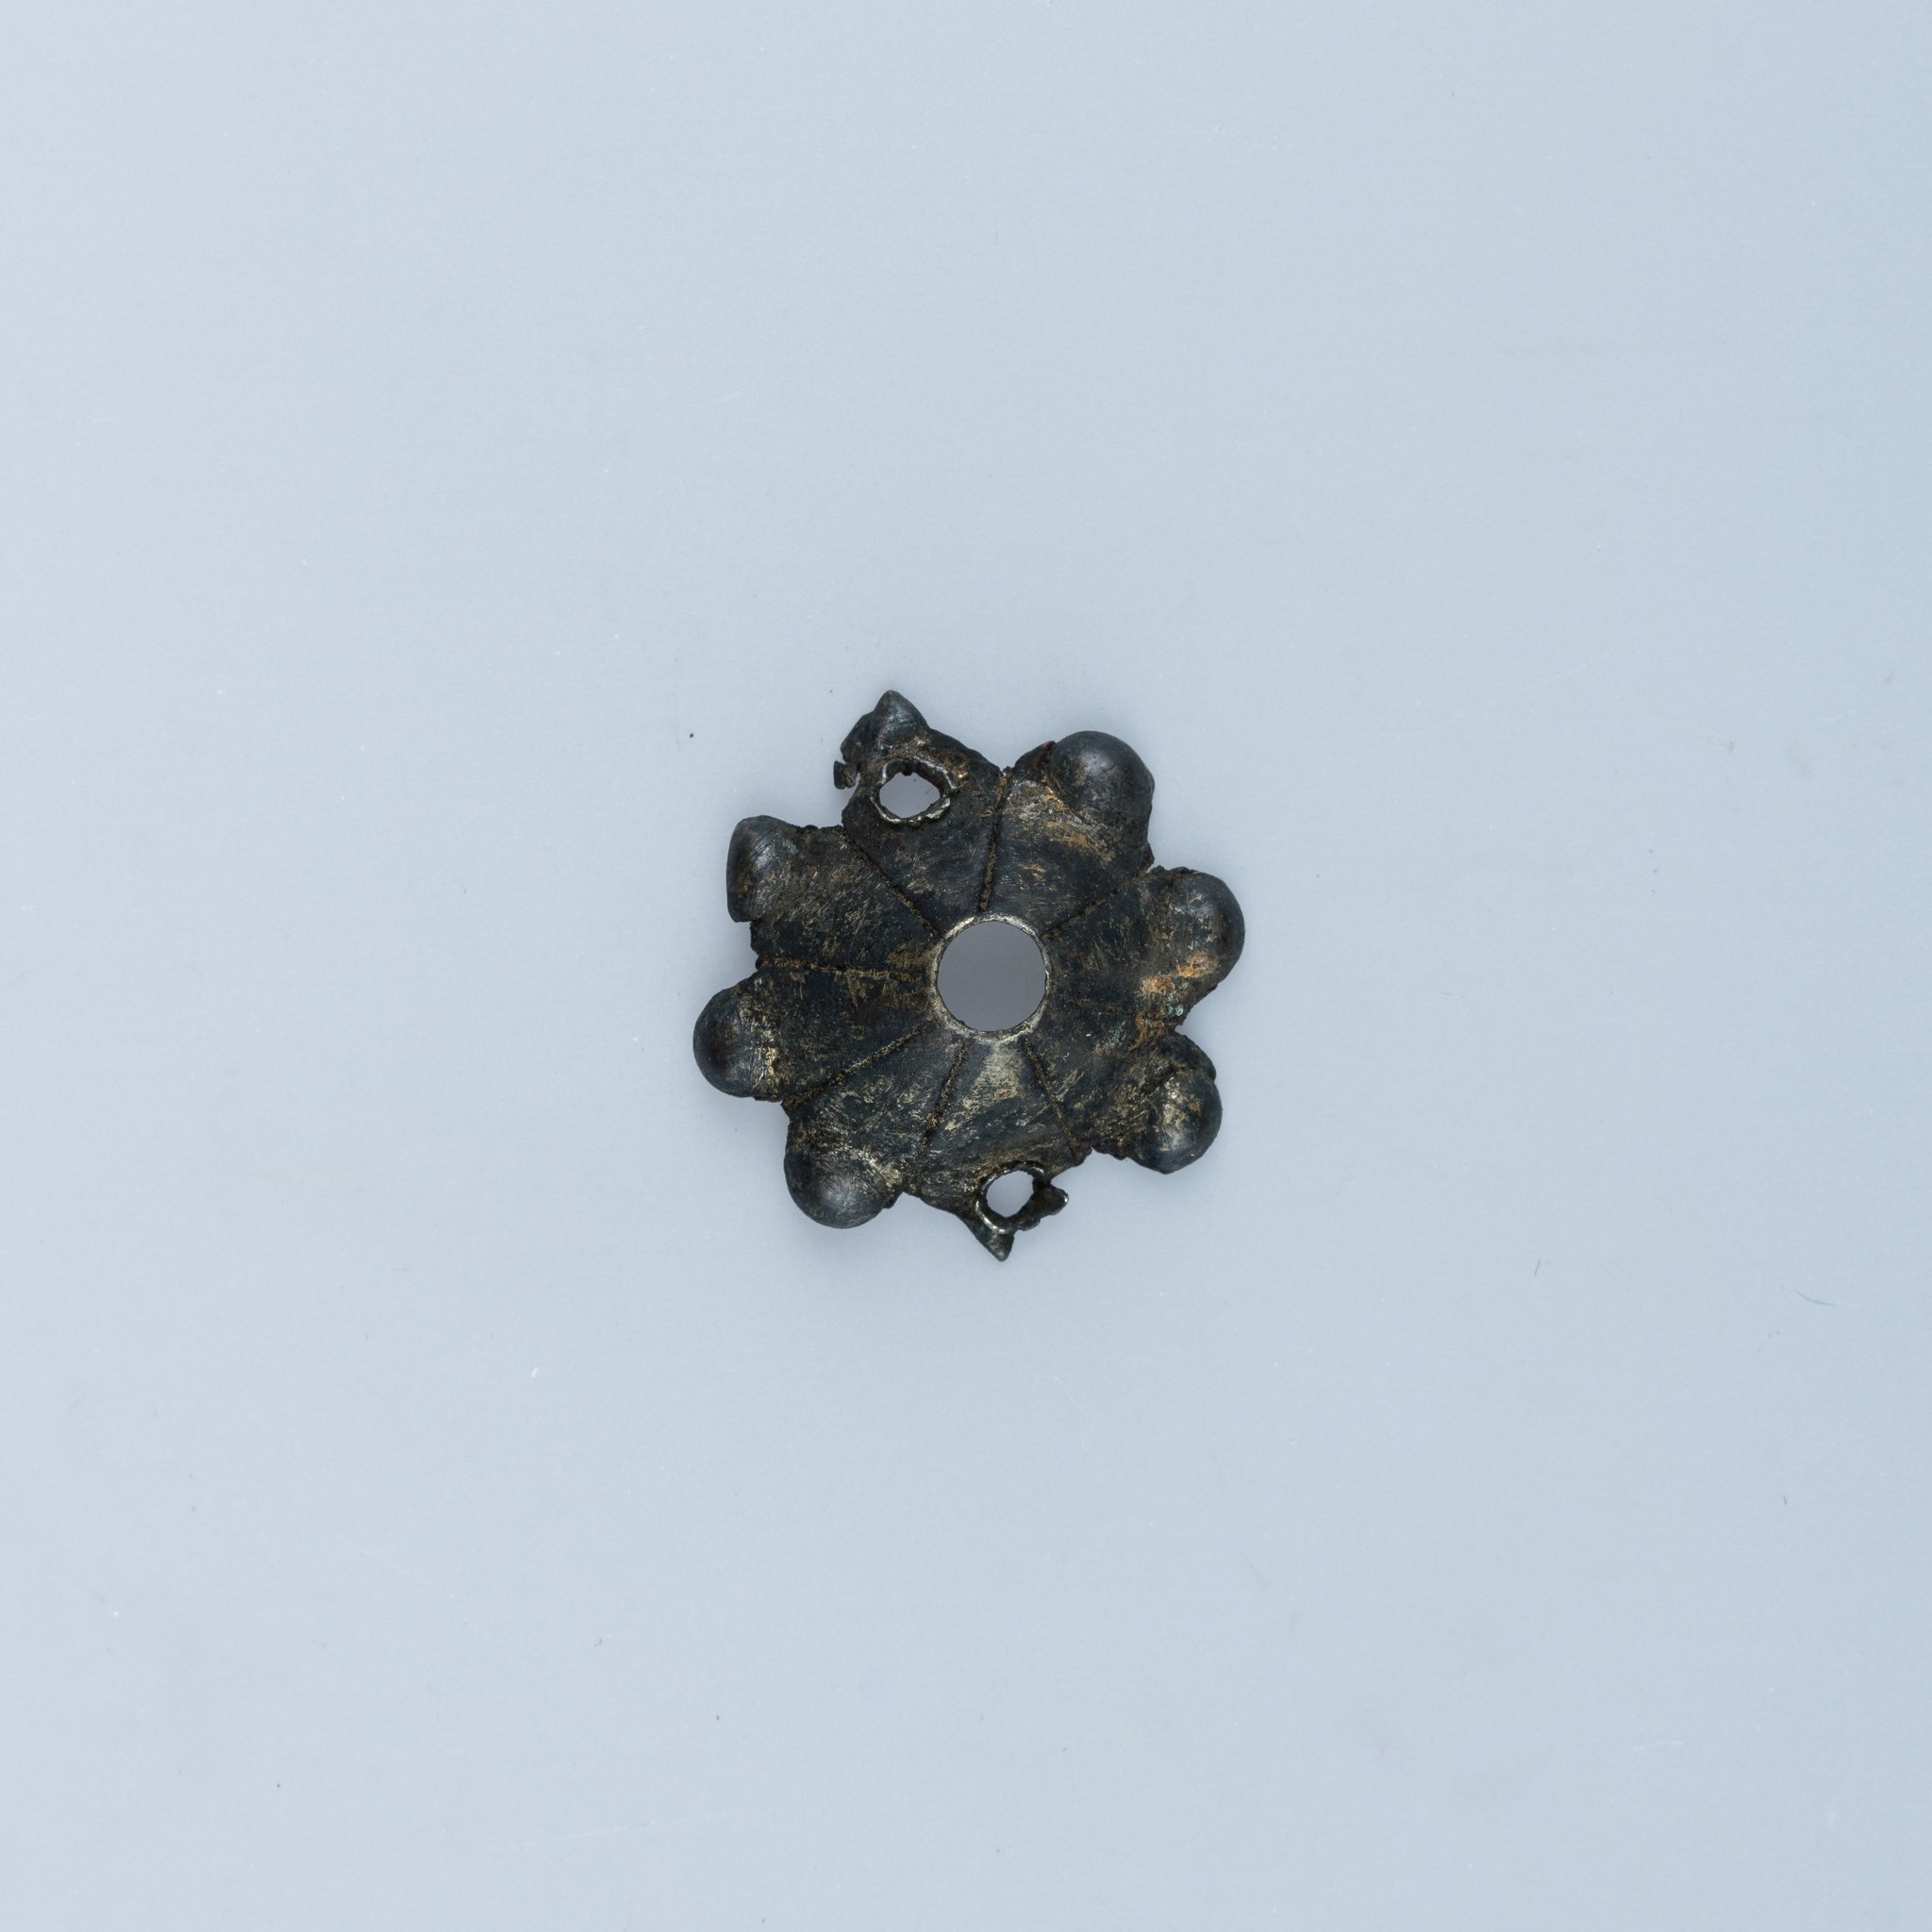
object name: rosette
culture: italian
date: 1301-1400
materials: bronze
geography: italy